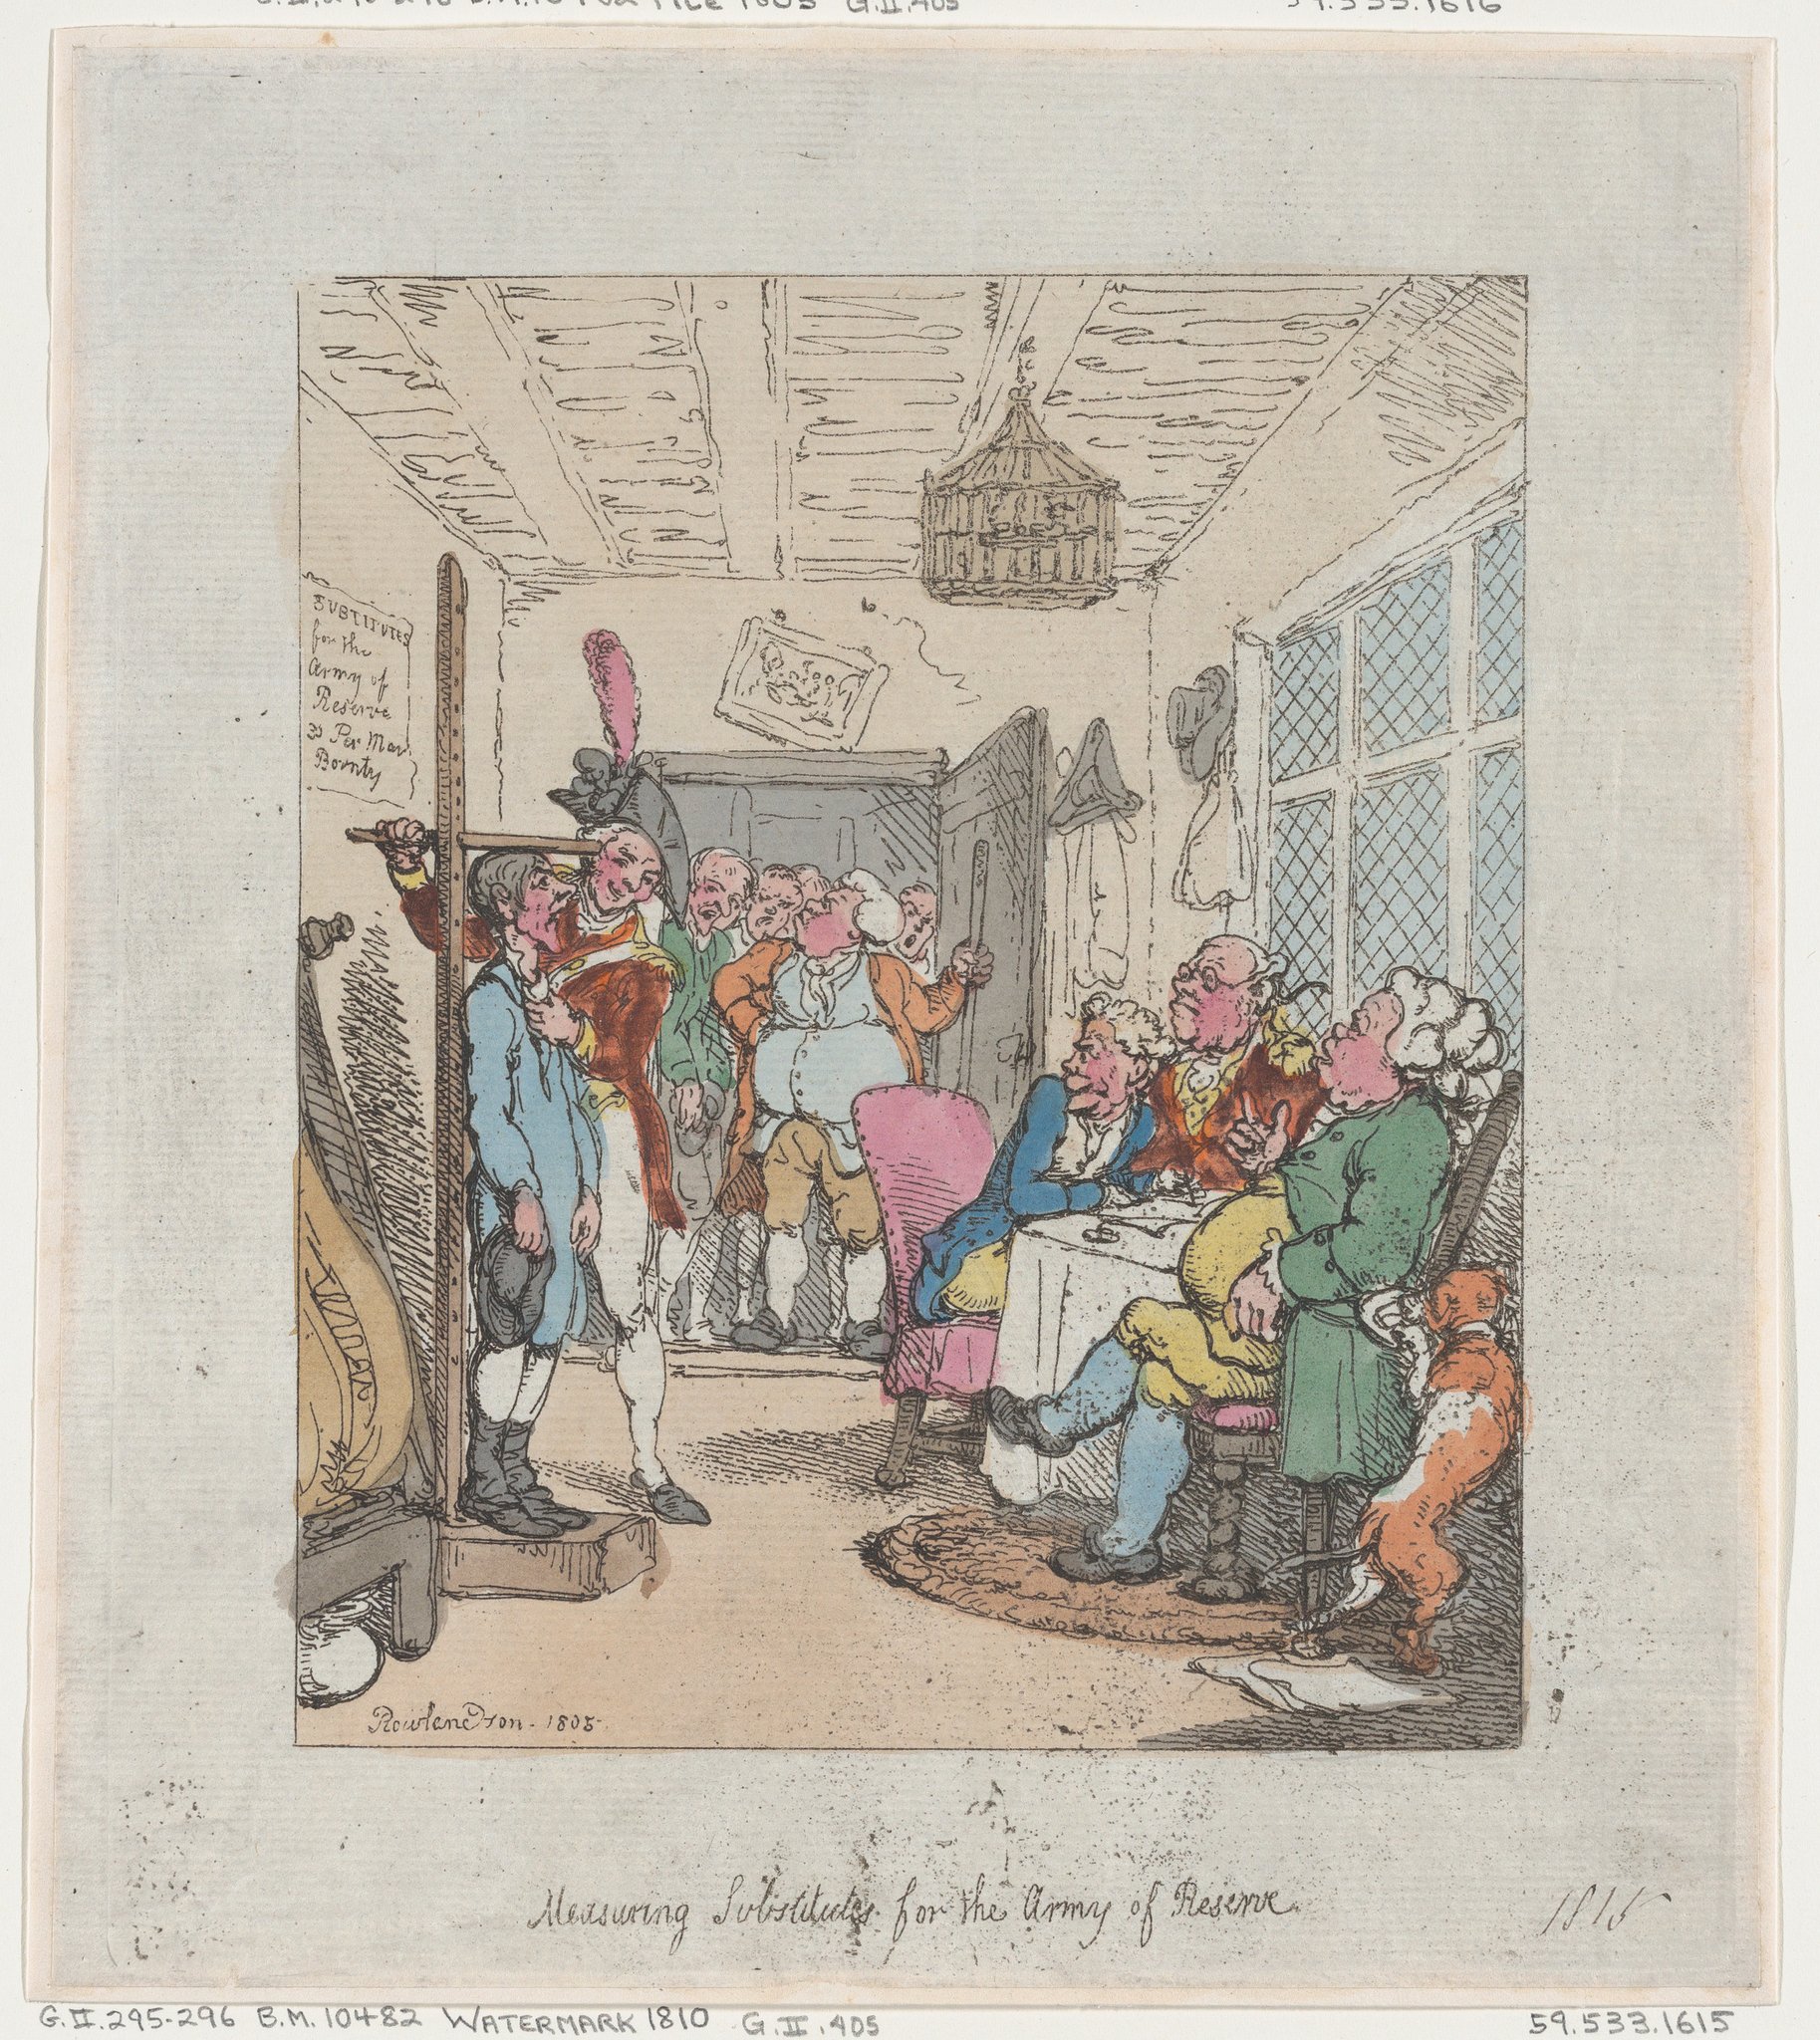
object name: print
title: Measuring Substitutes for the Army of Reserve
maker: thomas rowlandson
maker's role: artist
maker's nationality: british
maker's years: 1757-1827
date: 1805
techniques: etching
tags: satire,men,women